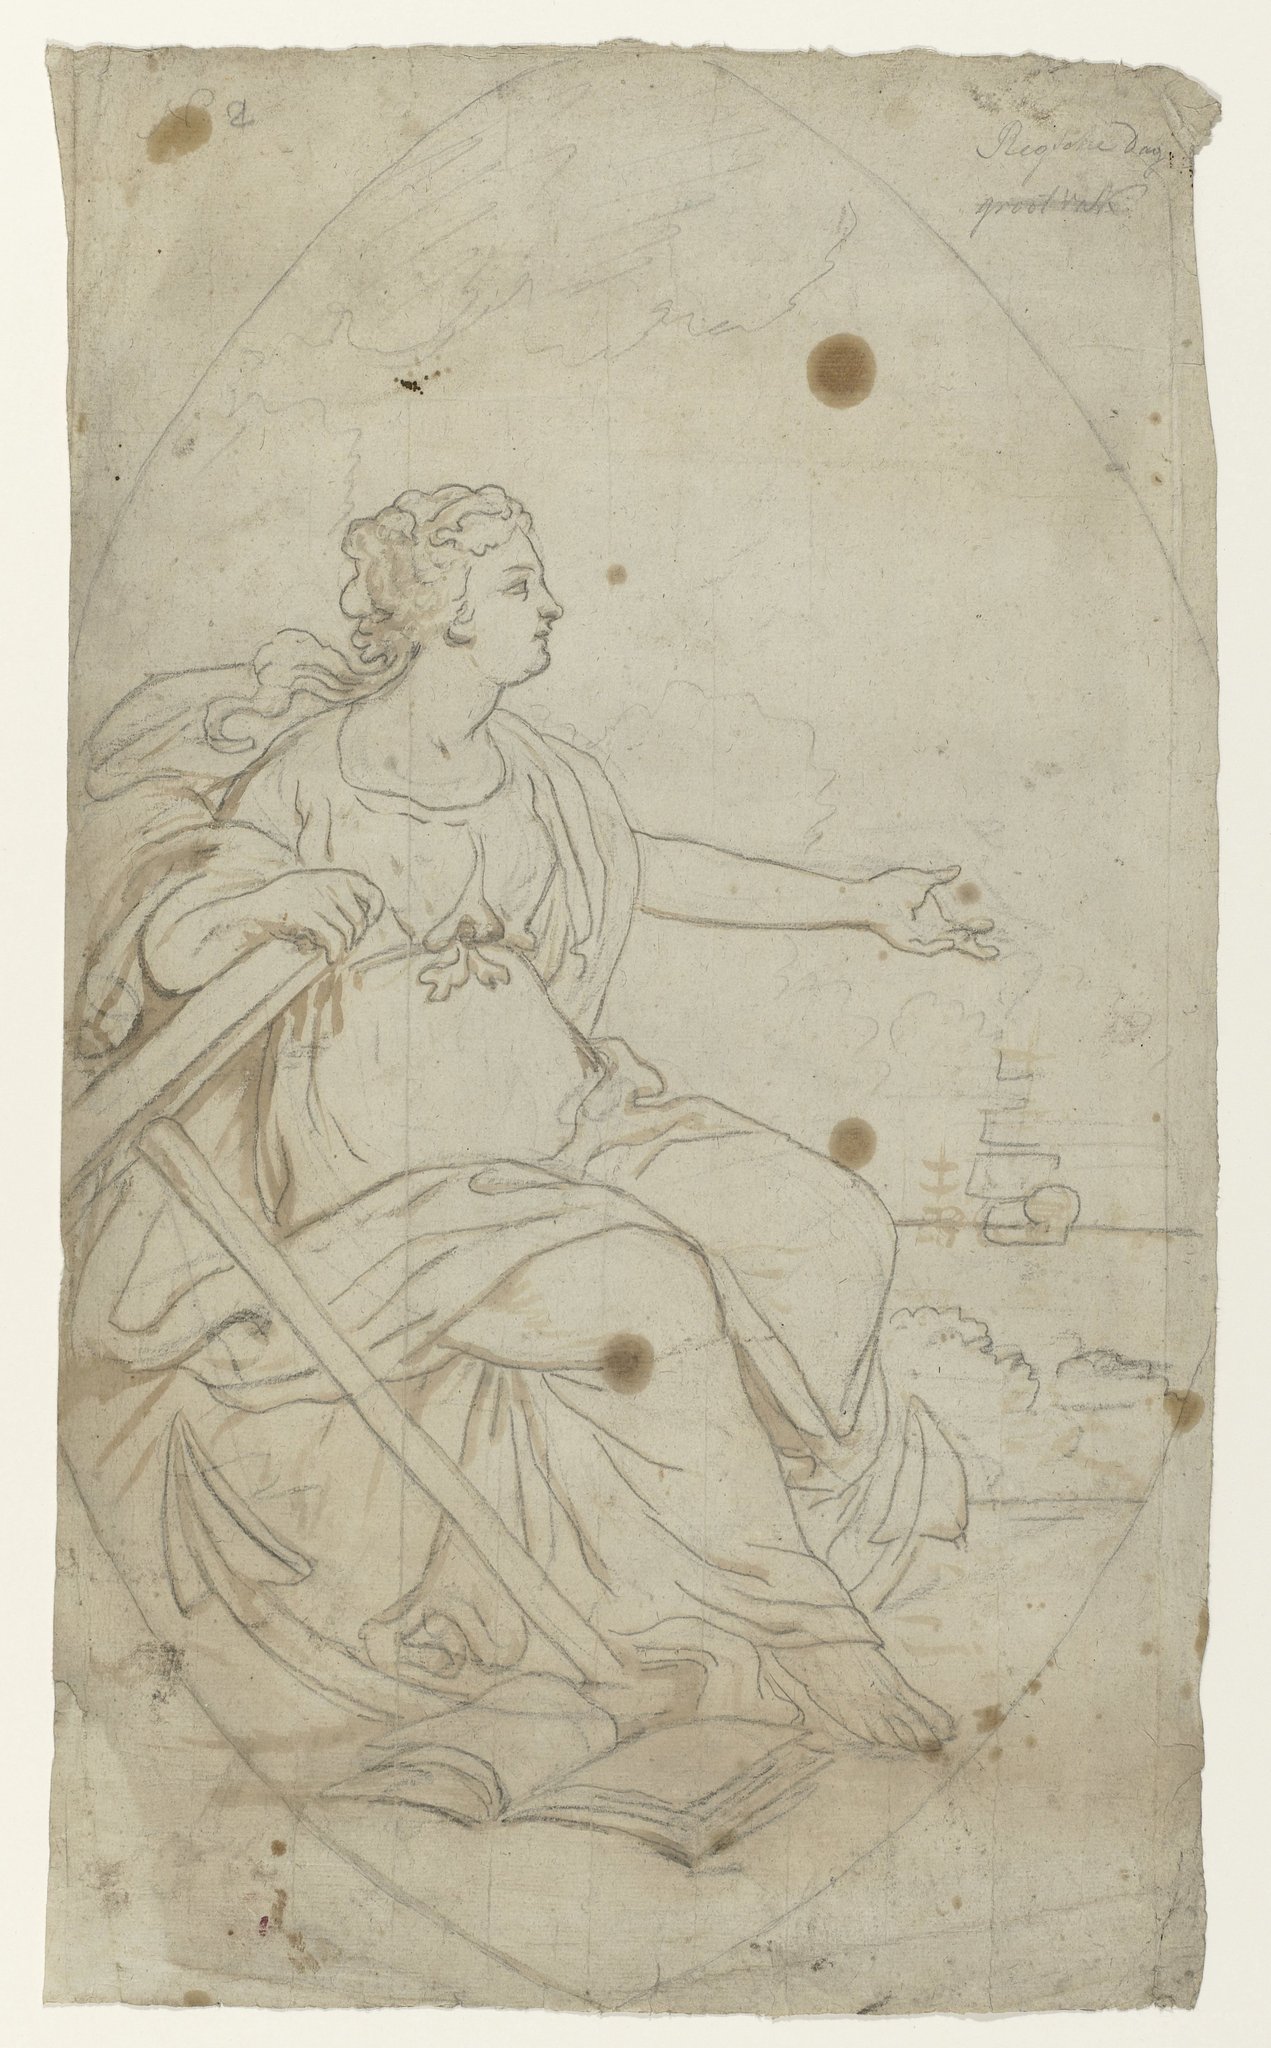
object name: drawing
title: Allegorie op de scheepvaart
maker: abraham van strij (i)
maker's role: draughtsman, painter, print maker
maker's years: 1753-1826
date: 1763-1826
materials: chalk, paper, pencil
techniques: brush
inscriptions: annotation: ‘Regsche dag groot vak N2’